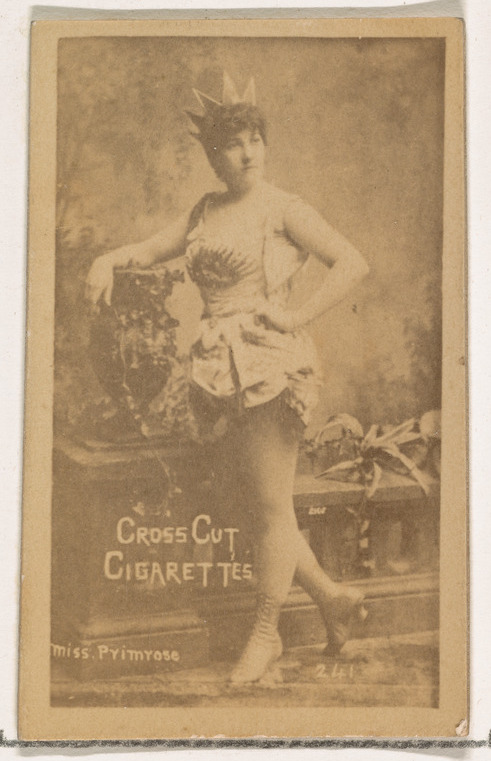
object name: print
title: Card Number 241, Miss Primrose, from the Actors and Actresses series (N145-1) issued by Duke Sons & Co. to promote Cross Cut Cigarettes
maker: w. duke, sons & co.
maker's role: publisher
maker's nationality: american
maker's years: 1870-1920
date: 1880-1889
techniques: albumen silver print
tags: portraits,women,actresses